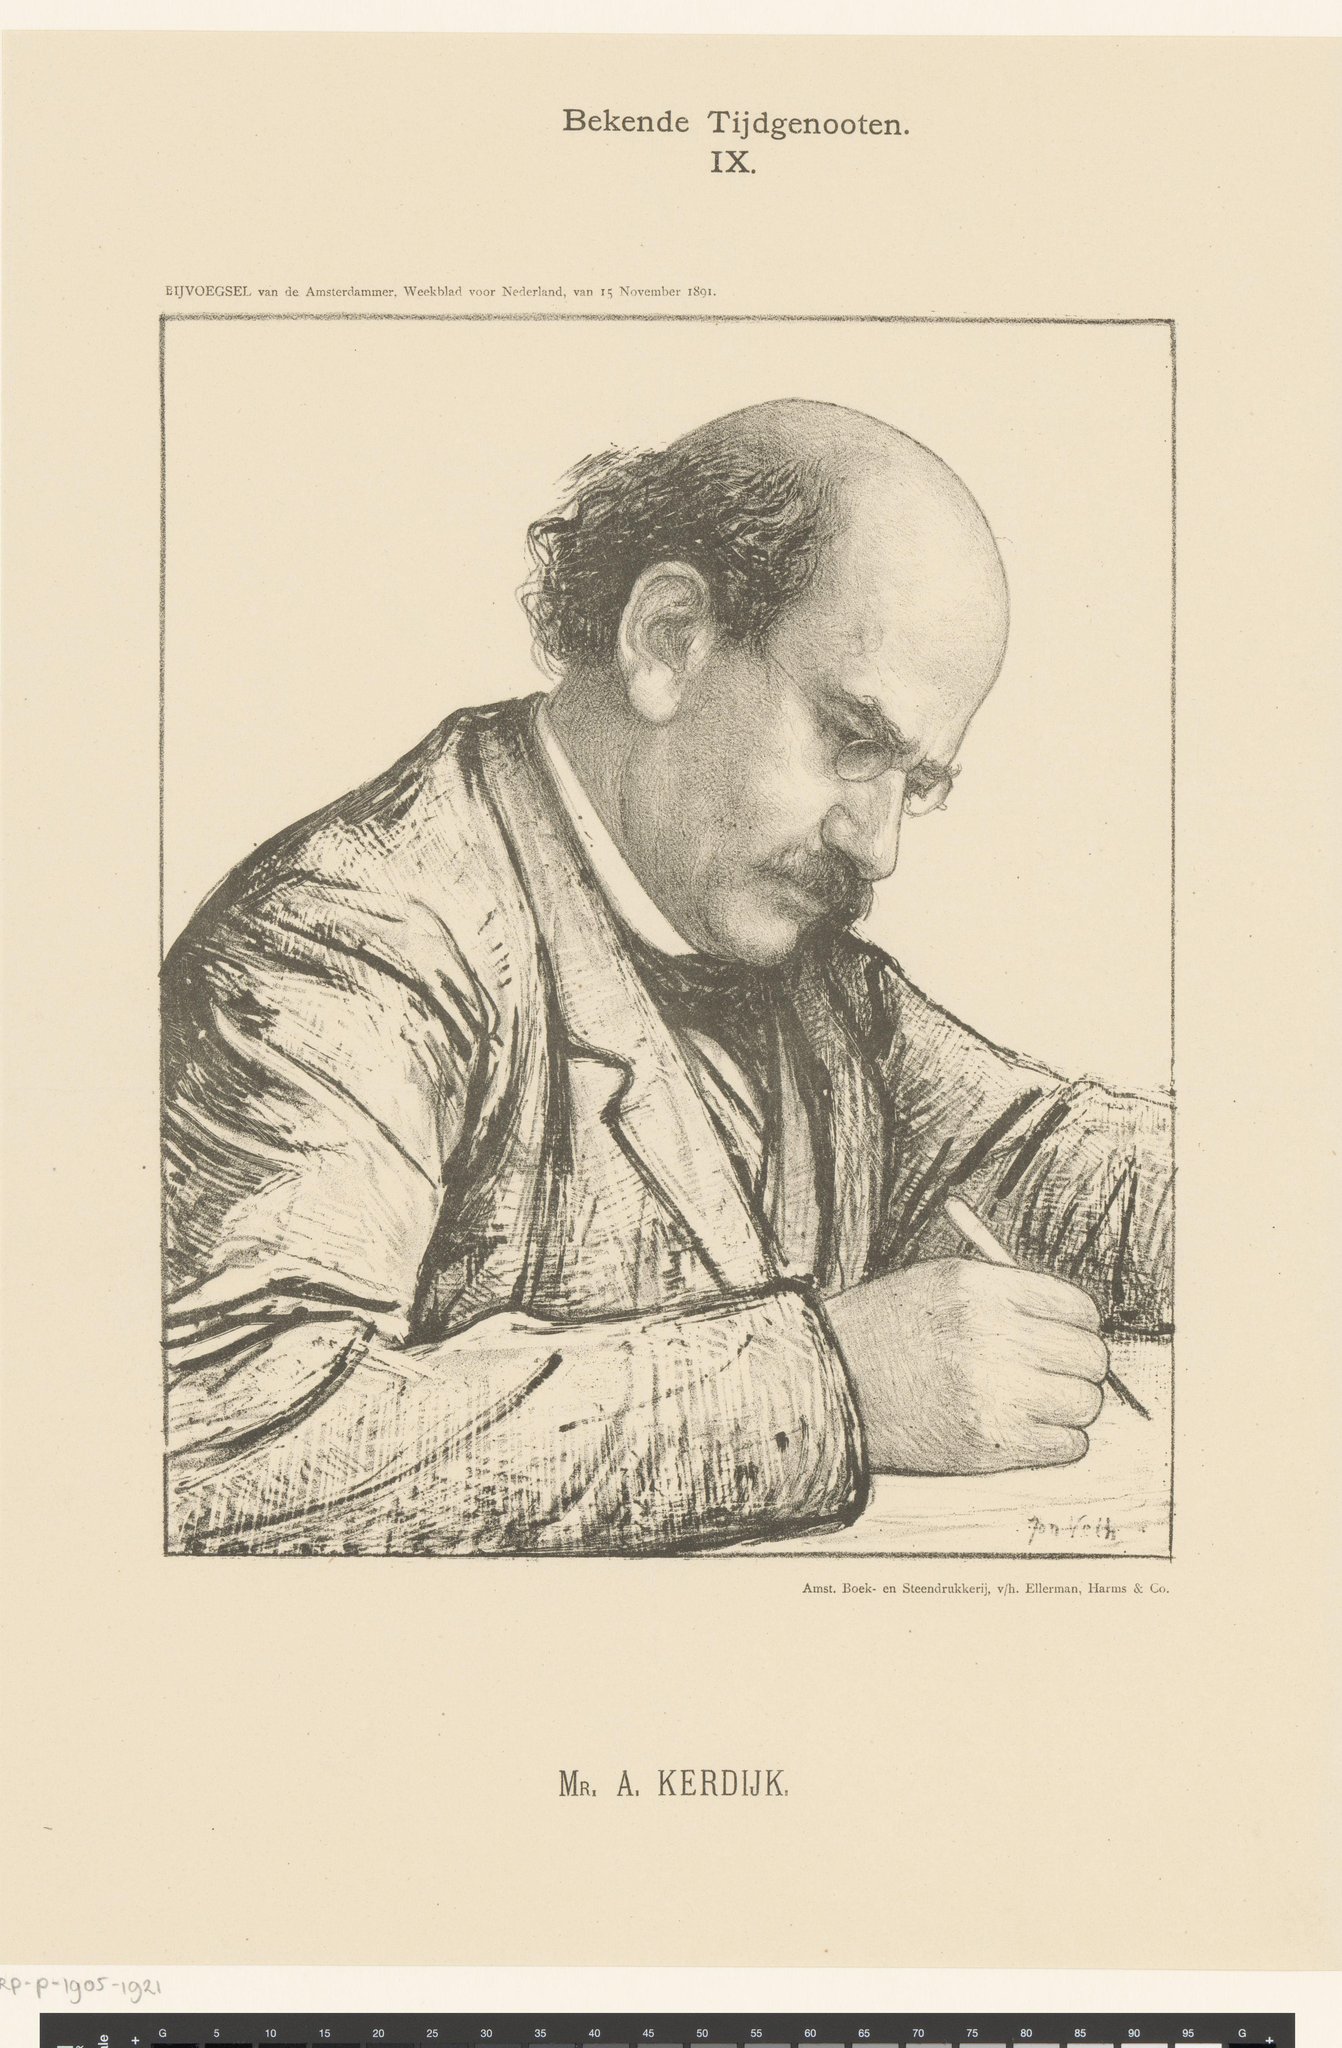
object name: print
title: Bekende Tijdgenooten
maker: jan veth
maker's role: designer, draughtsman, painter, print maker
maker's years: 1864-1925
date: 1891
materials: paper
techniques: lithograph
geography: amsterdam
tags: politician, writing and letters, historical persons (+ (full) bust portrait)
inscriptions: collector's mark: Lugt 2228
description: Deze prent werd uitgegeven bij De Amsterdammer van 15 november 1891.